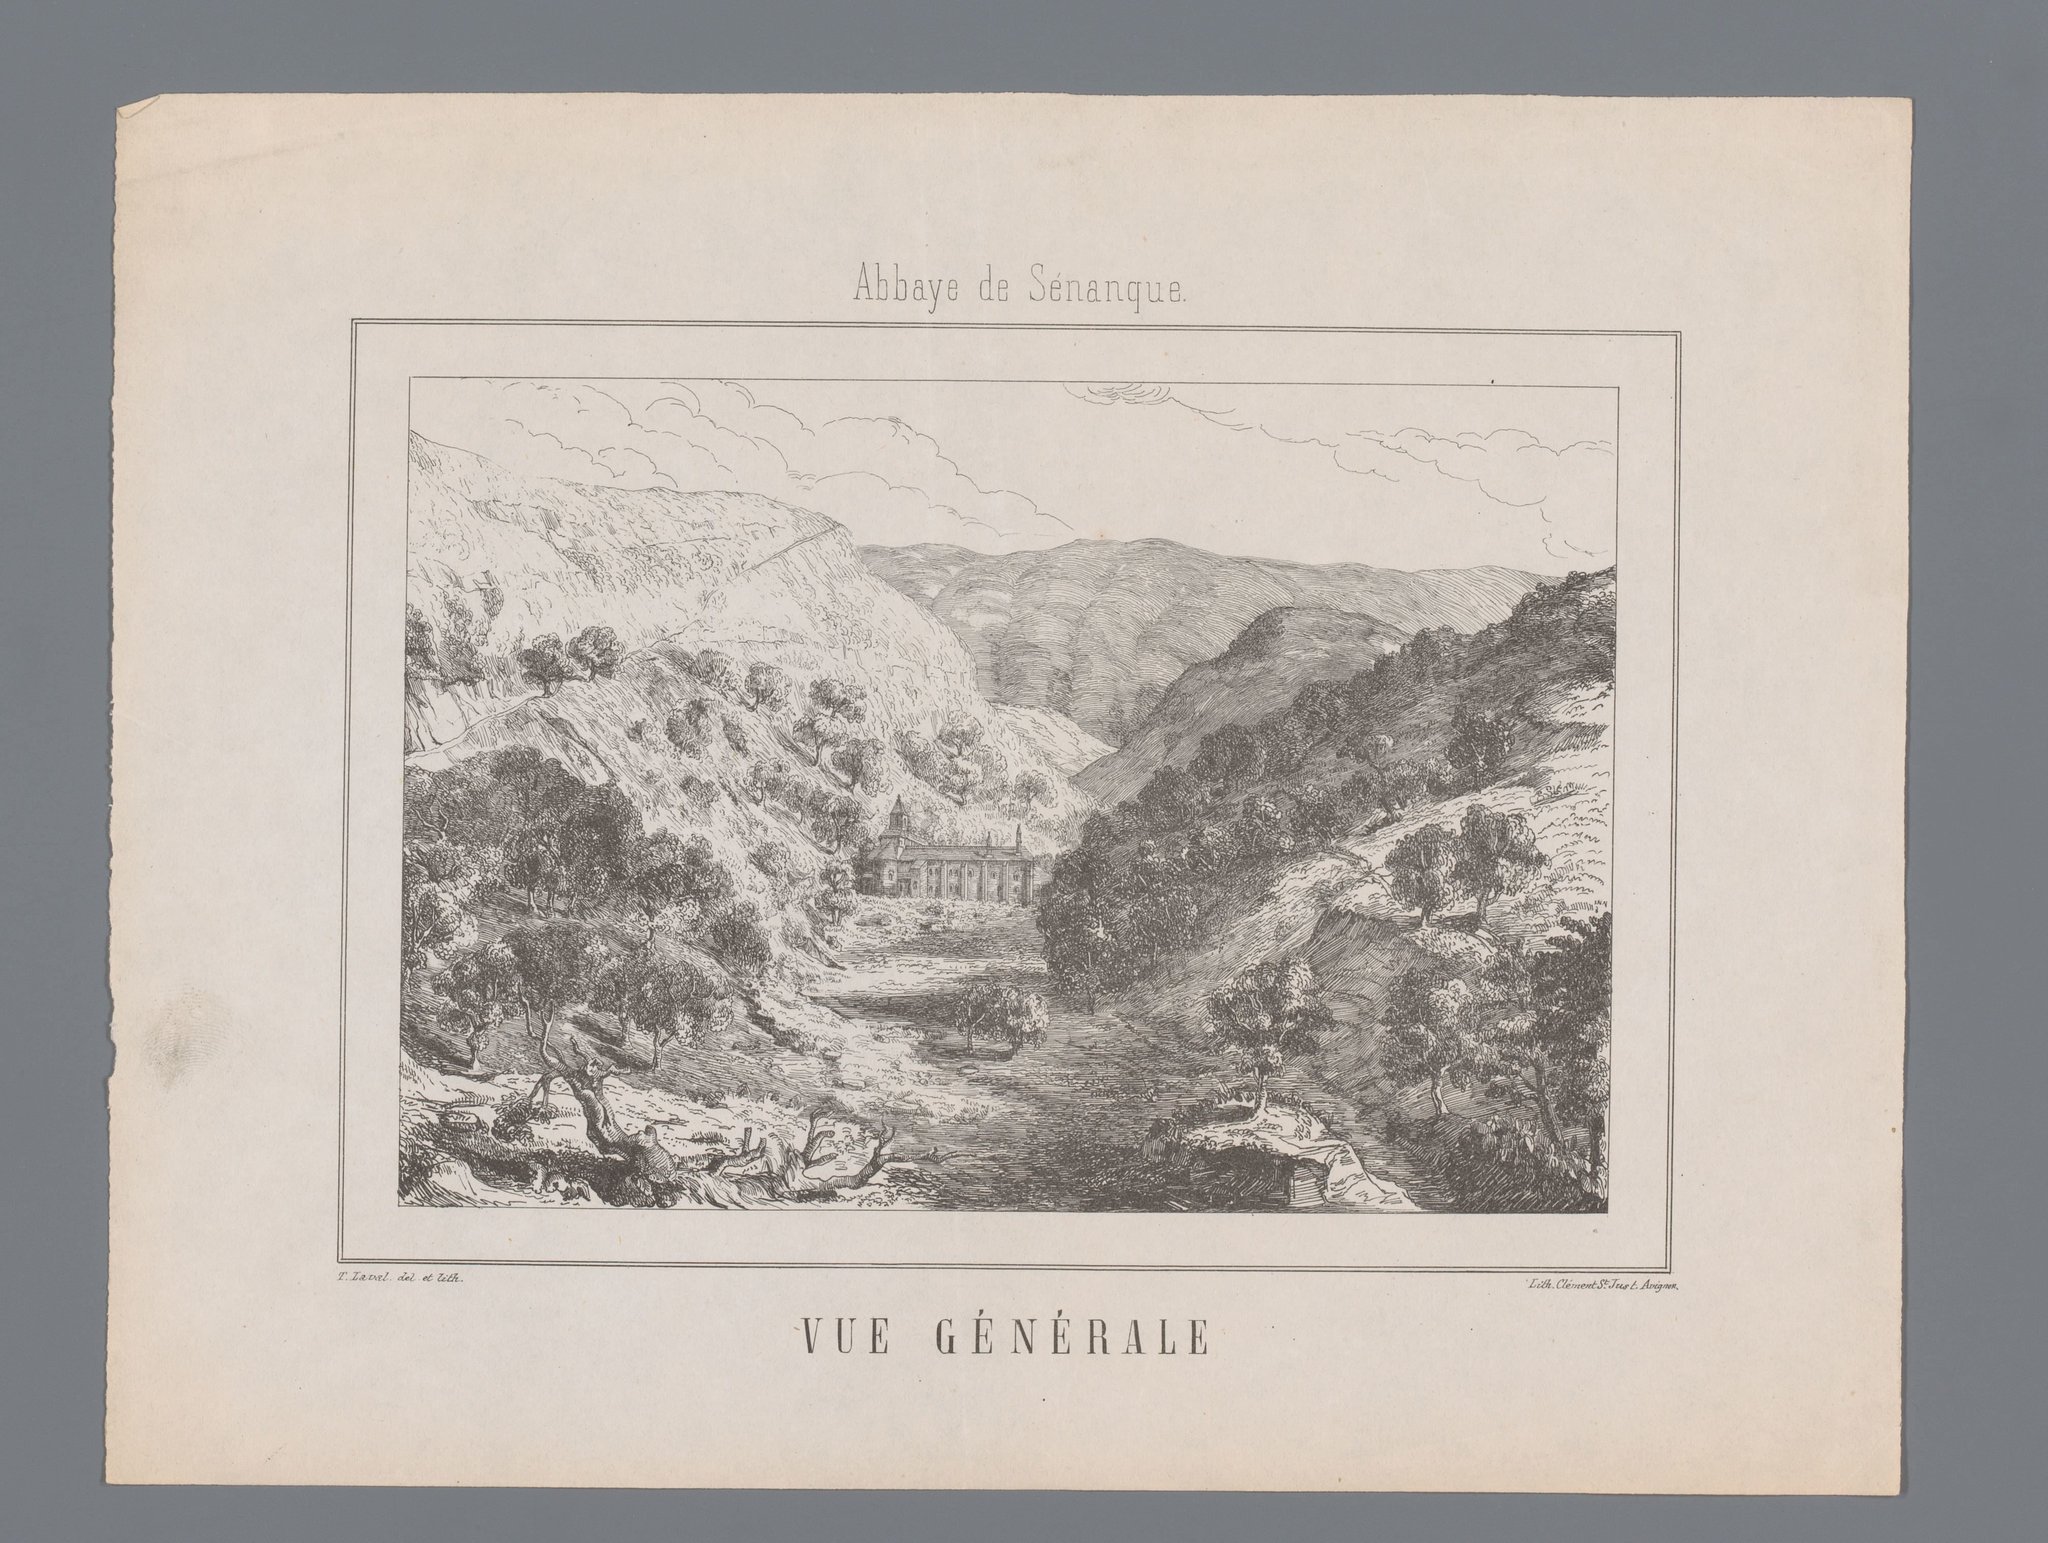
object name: print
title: Gezichten in en bij de Abdij van Sénanque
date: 1855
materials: paper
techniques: lithograph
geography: avignon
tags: abbey, monastery, convent ~ roman catholic church, (high) hill